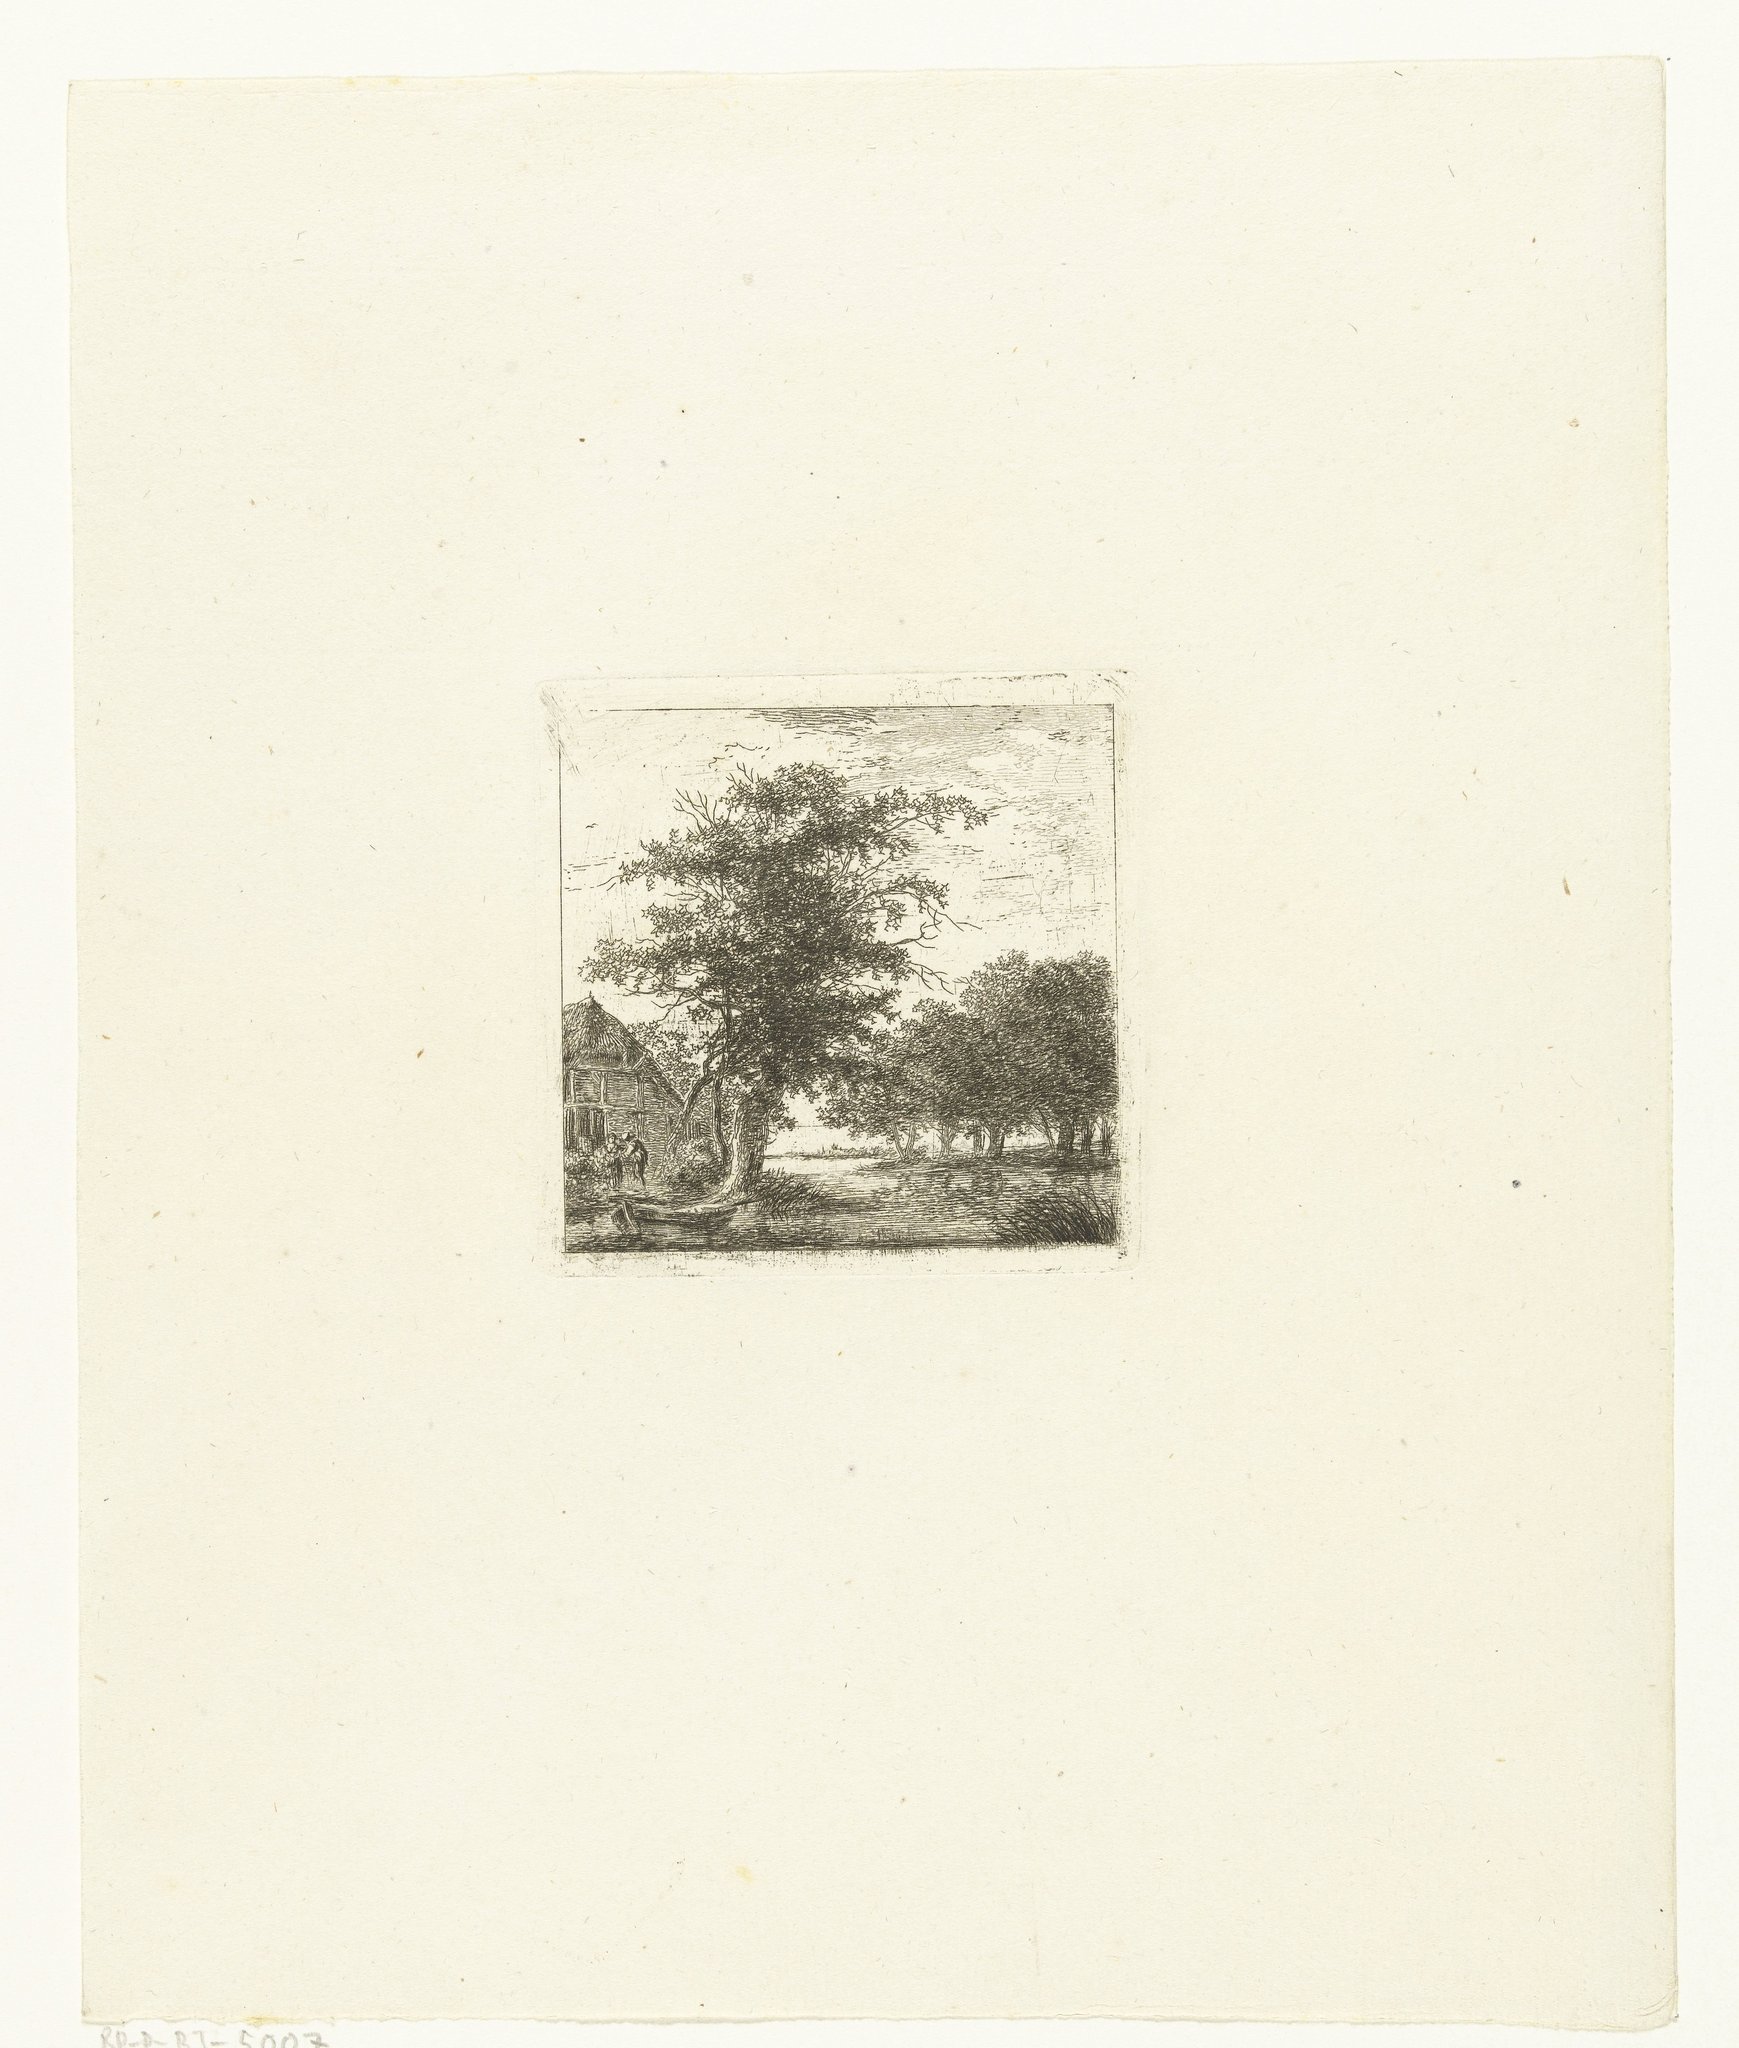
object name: print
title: Rivier in boomrijk landschap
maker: hermanus van brussel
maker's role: draughtsman, print maker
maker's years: 1763-1815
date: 1800-1815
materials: paper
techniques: etching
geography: netherlands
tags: landscapes in the temperate zone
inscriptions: collector's mark: Lugt 2228